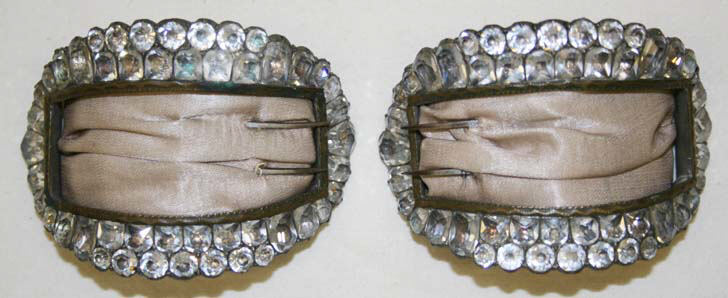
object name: shoe buckle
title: Shoe buckles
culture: british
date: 1701-1800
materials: metal, paste